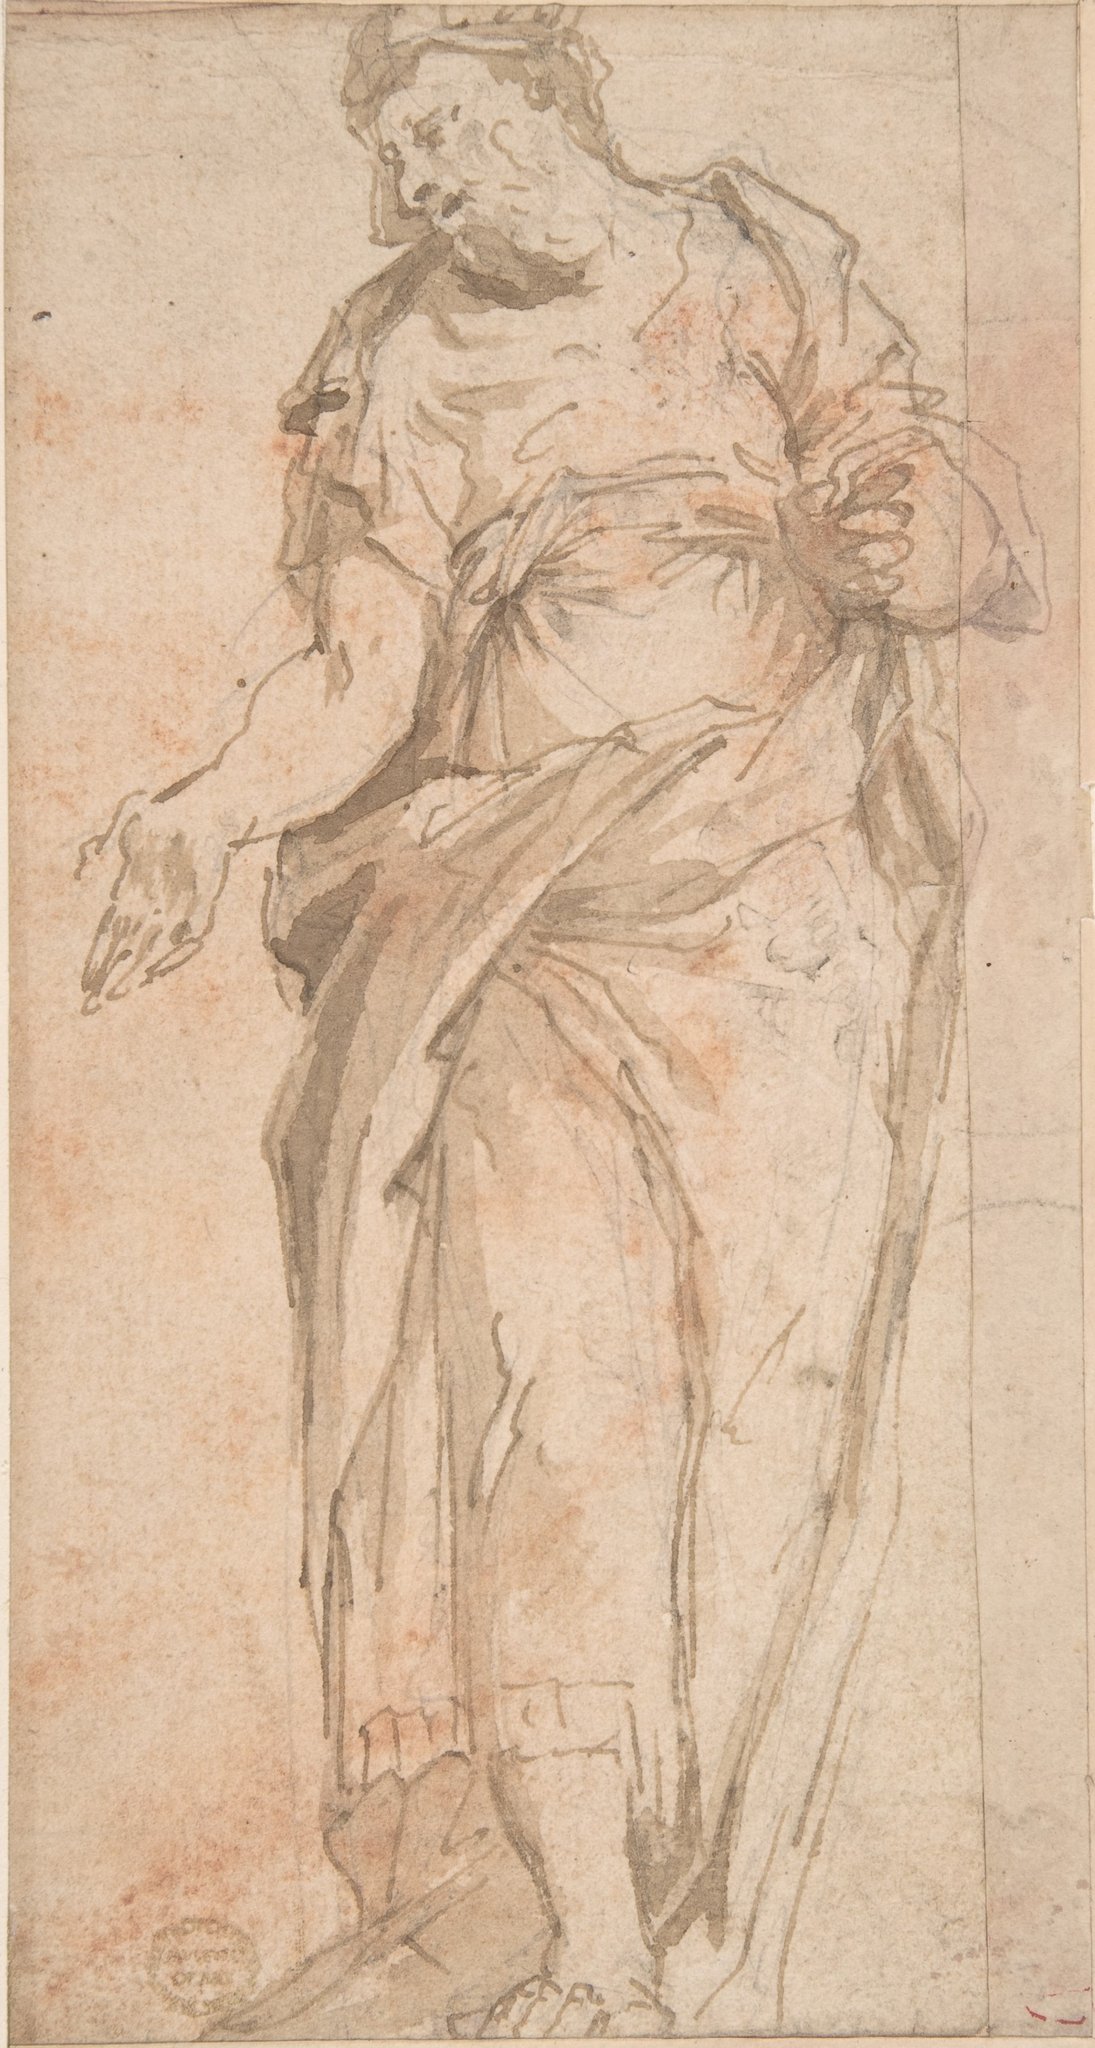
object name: drawing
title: Draped Male Figure Gesturing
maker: anonymous, italian, roman, 16th century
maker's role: artist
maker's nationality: italian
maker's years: 1500-1600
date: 1501-1600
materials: ink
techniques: brush, pen, wash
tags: men